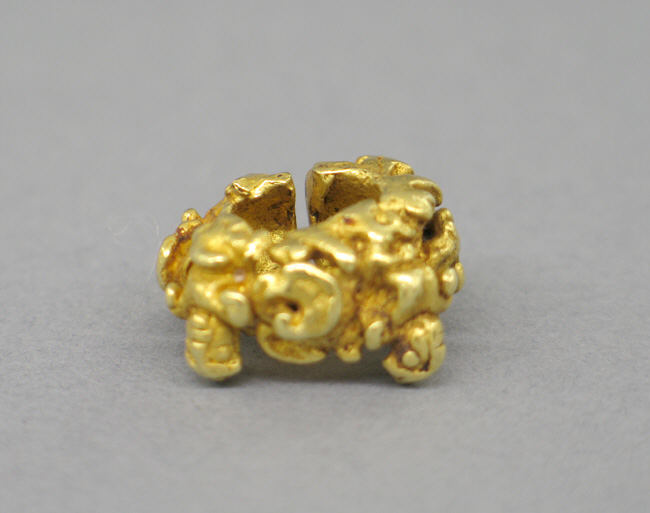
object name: ear clip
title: Ear Clip with Four Figures on a Foliate Ground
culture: indonesian, javanese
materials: gold